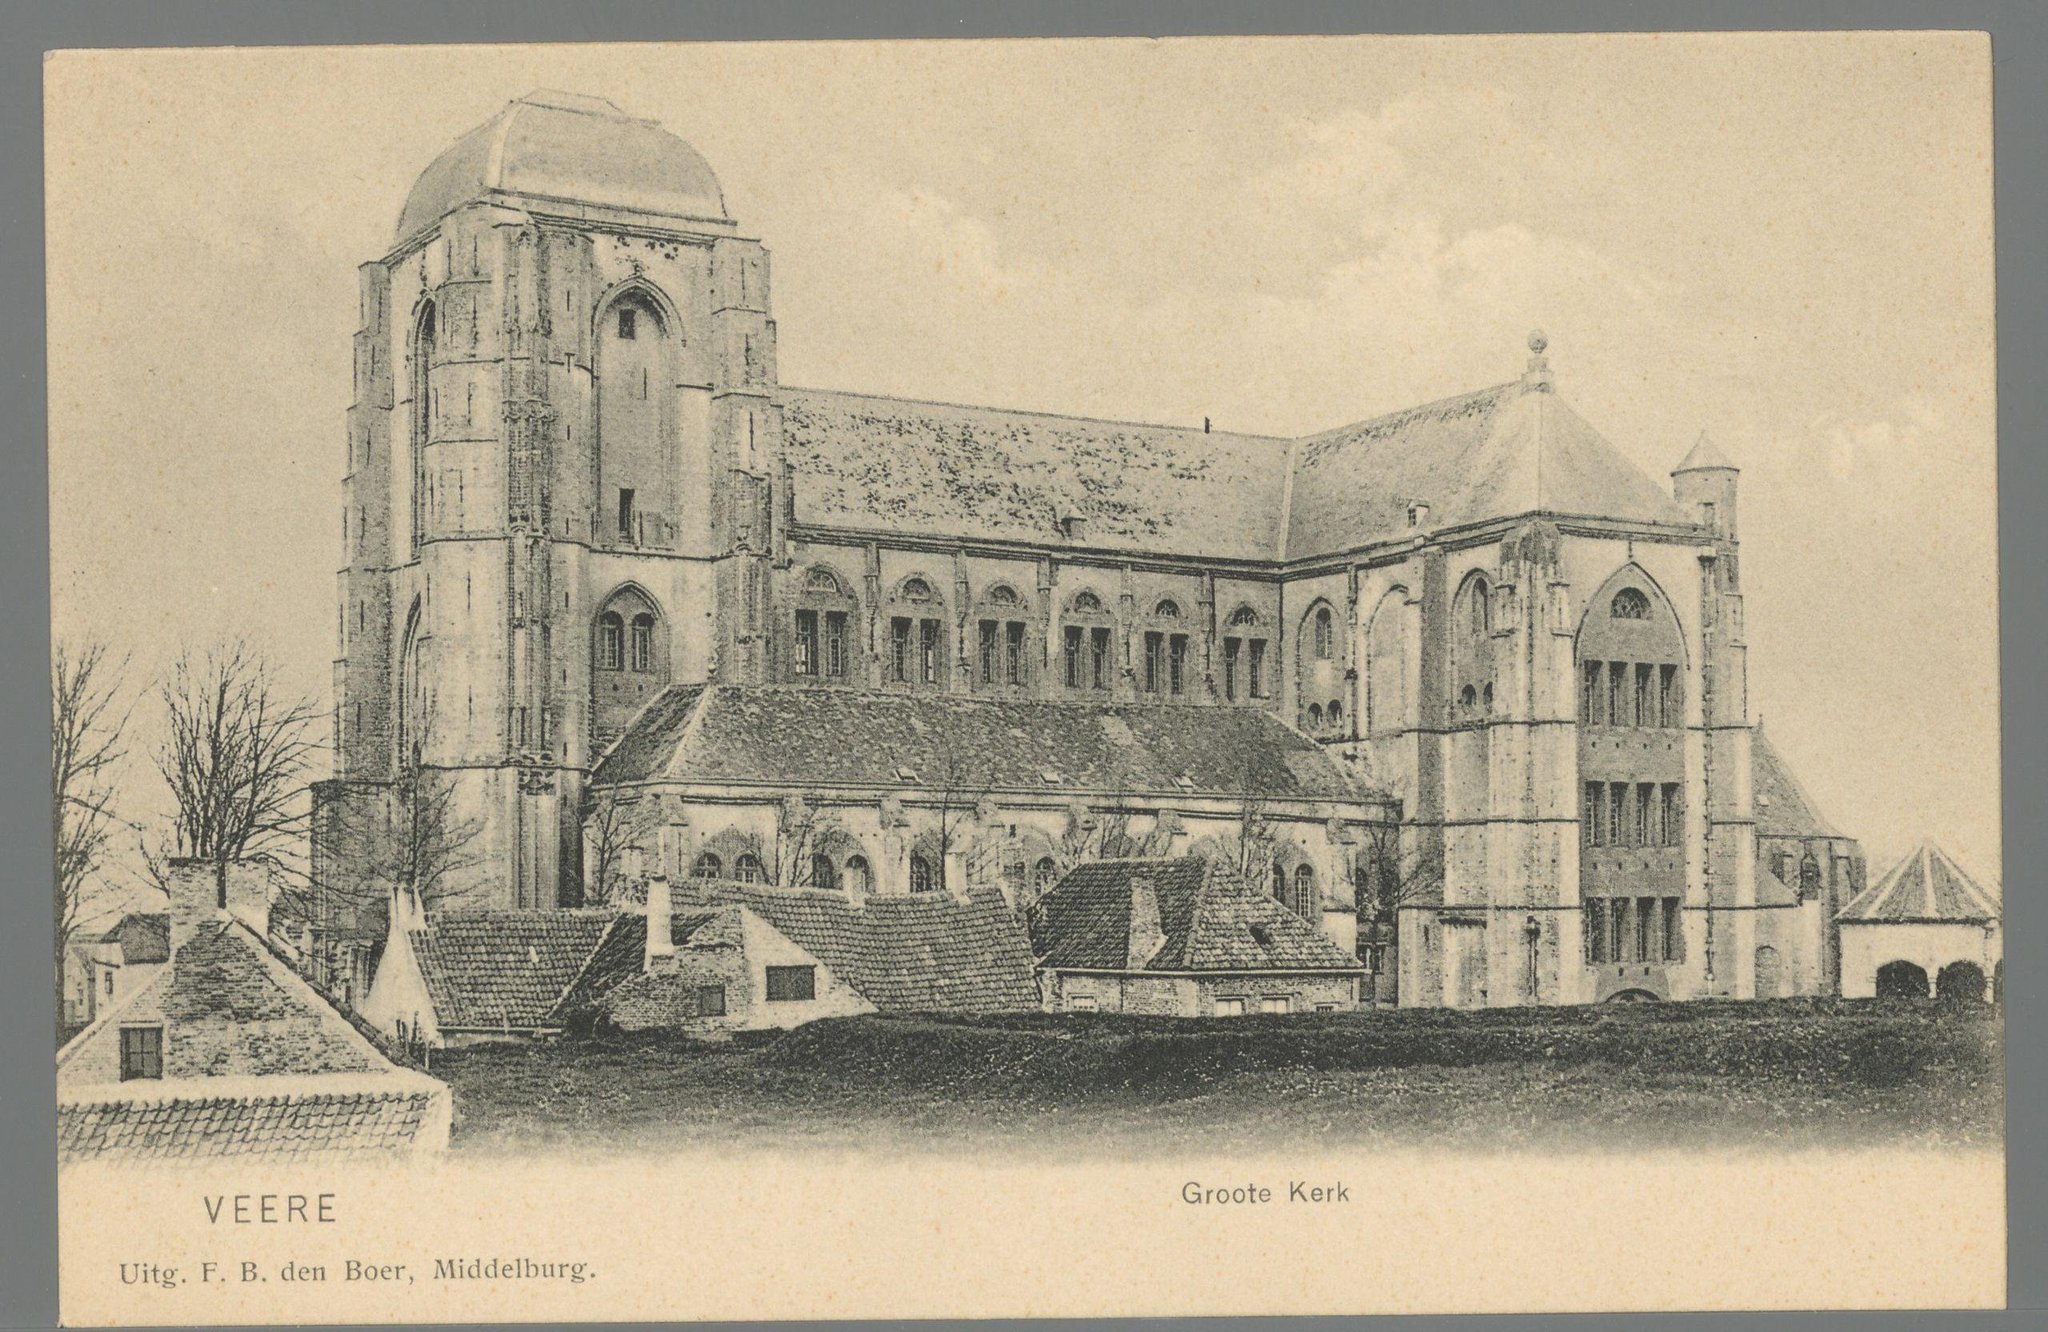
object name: photomechanical print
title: Veere. Groote Kerk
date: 1897-1905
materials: cardboard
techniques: photograph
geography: middelburg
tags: church (exterior)